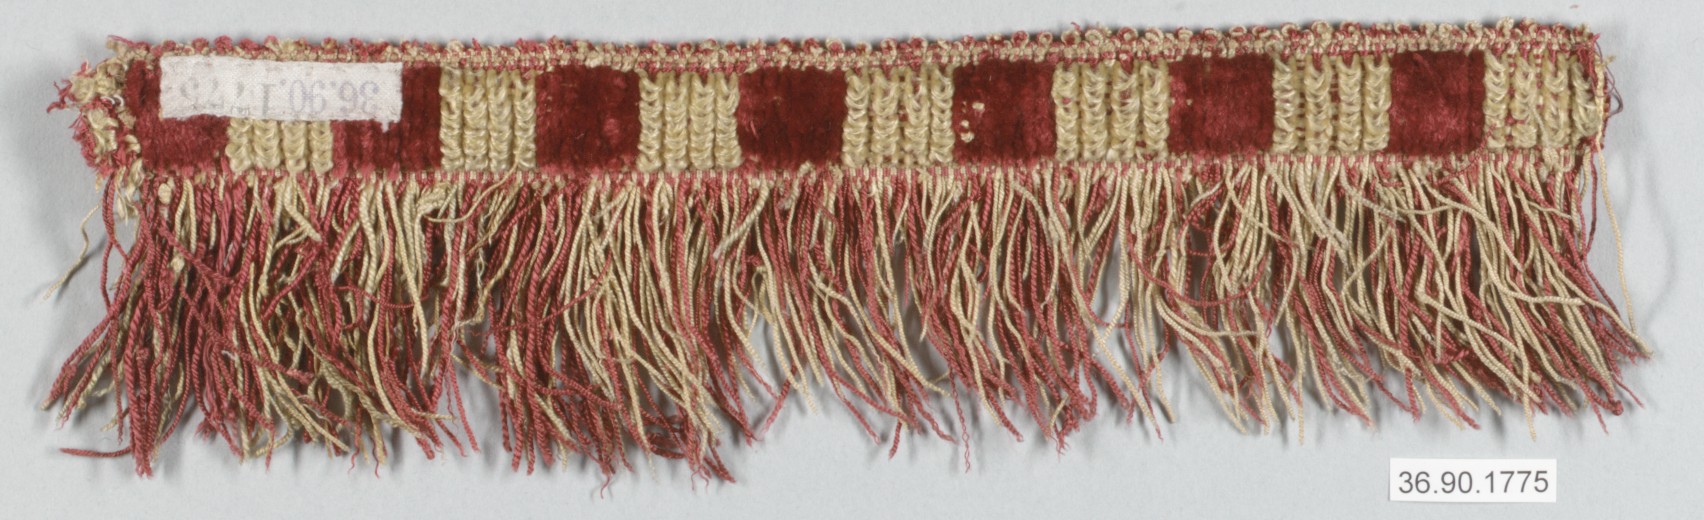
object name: fringe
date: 1750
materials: silk